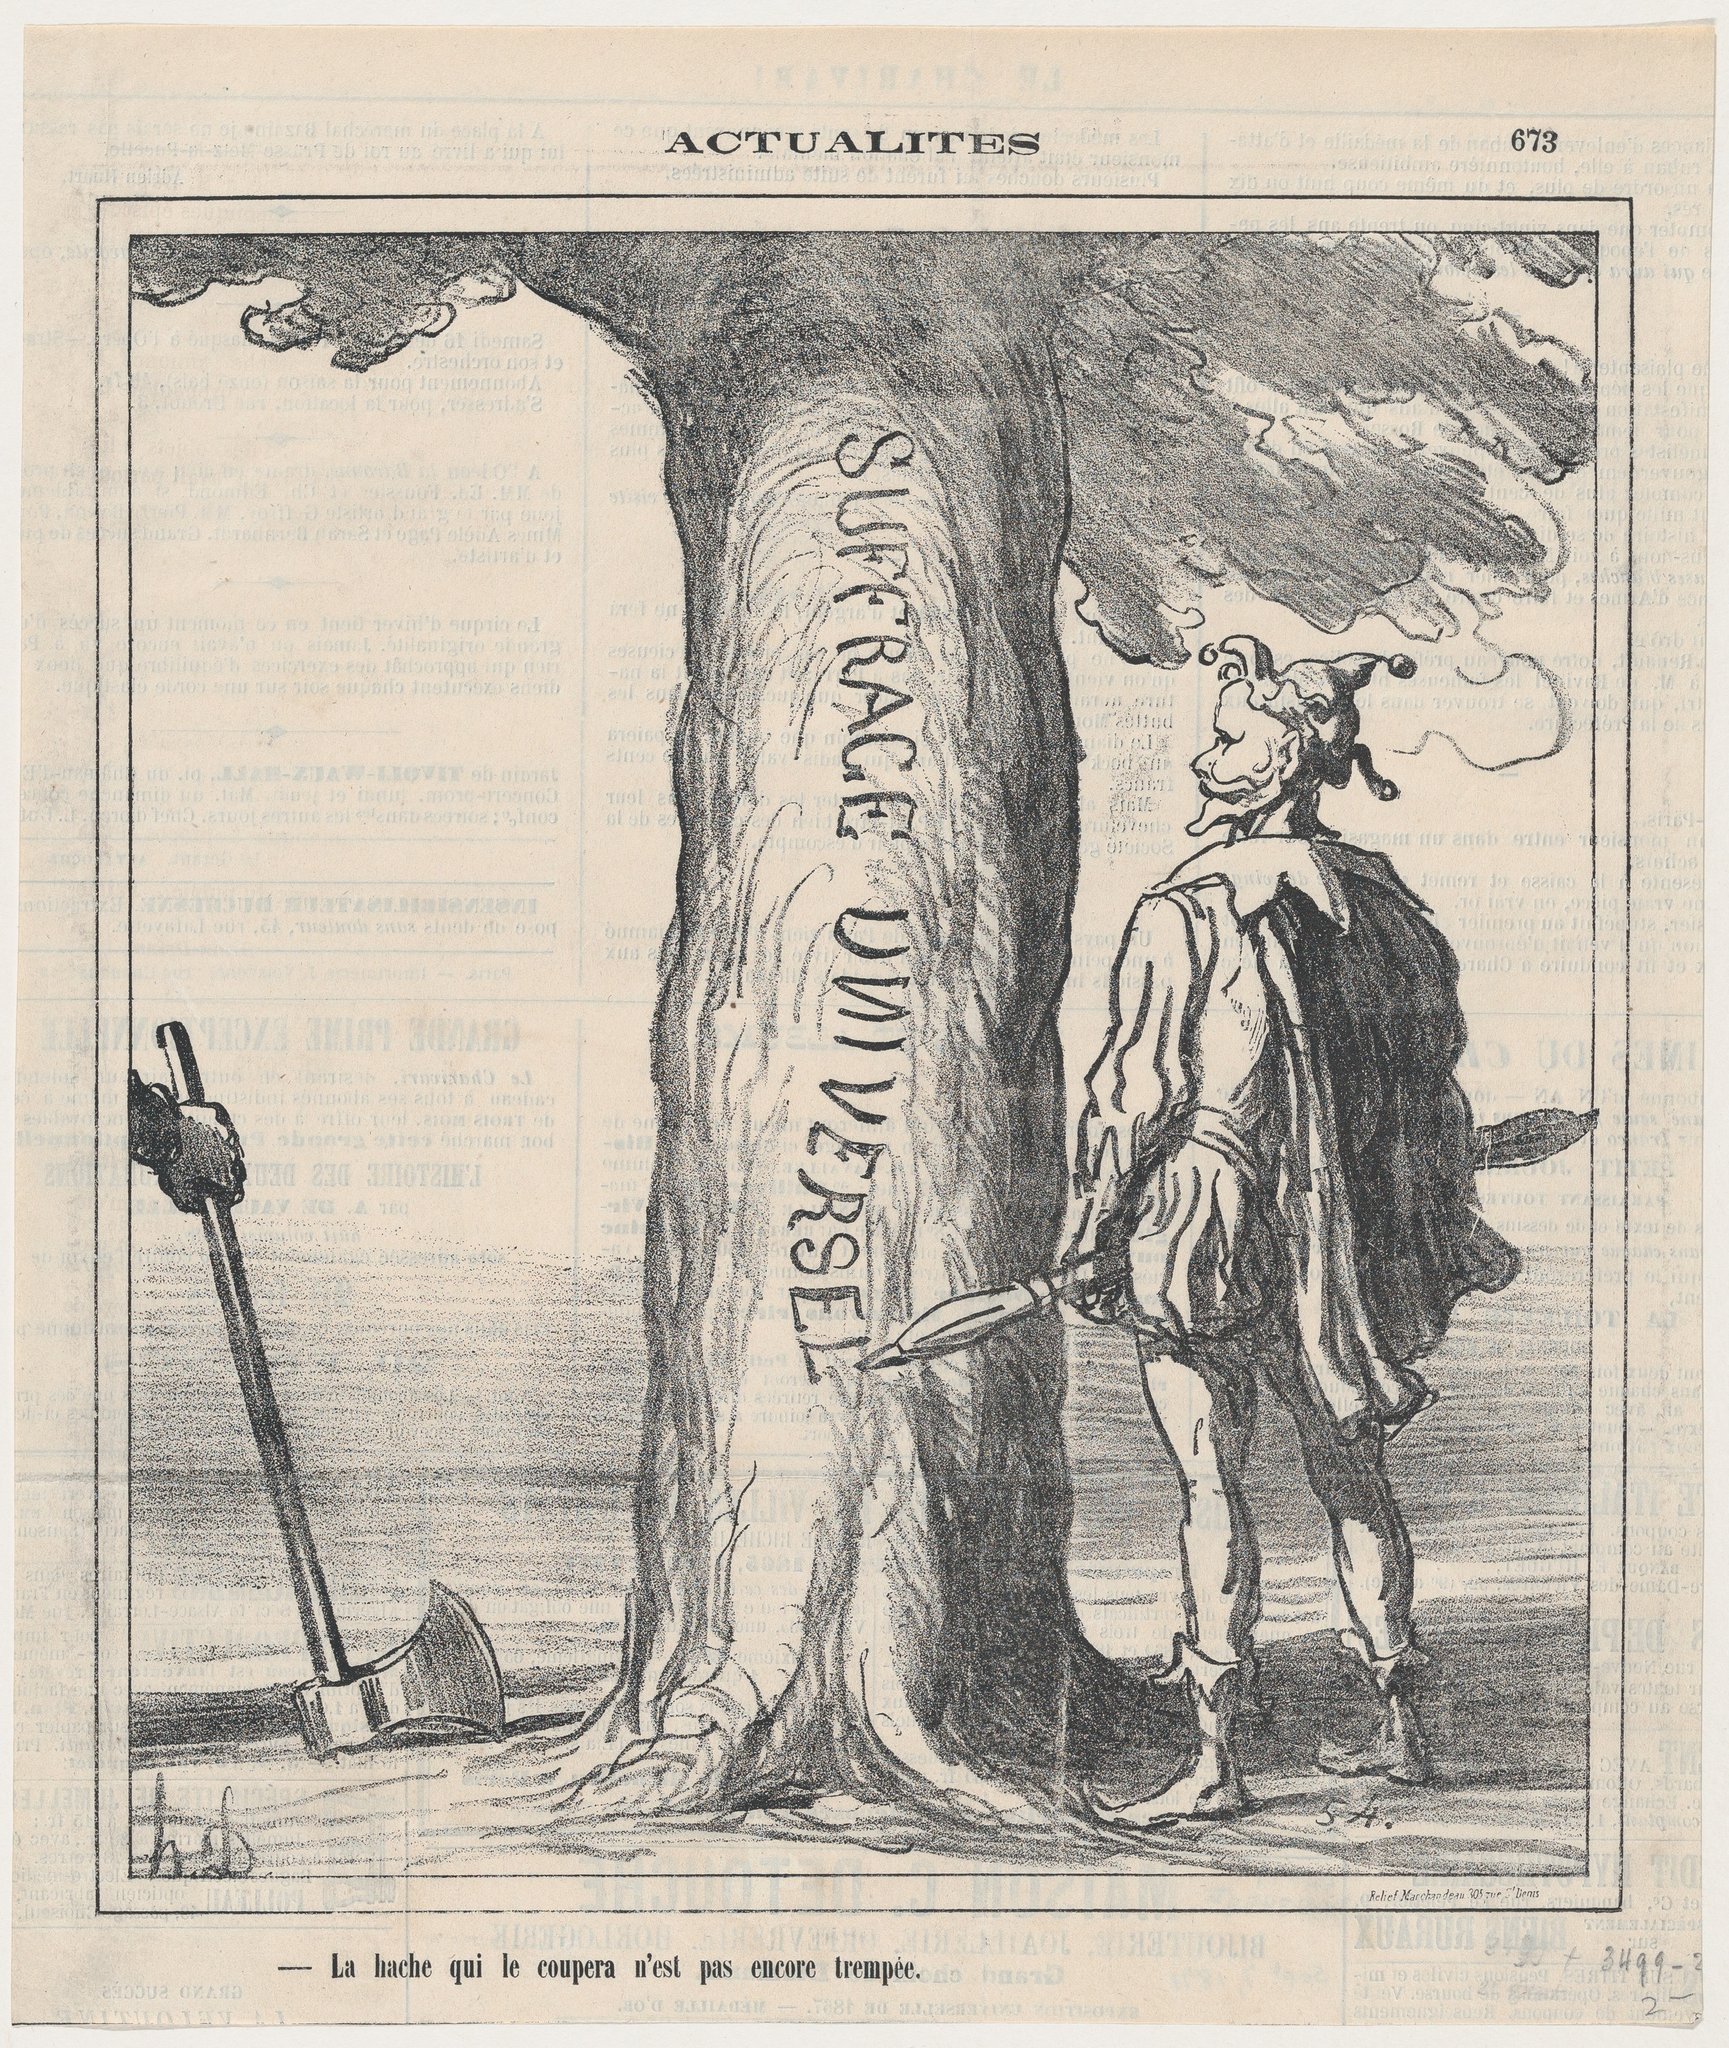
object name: print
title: The axe that may cut him has not been forged yet, from 'News of the day,' published in "Le Charivari"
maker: honoré daumier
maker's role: artist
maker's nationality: french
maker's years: 1808-1879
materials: paper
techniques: lithograph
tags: satire,men,trees,axes